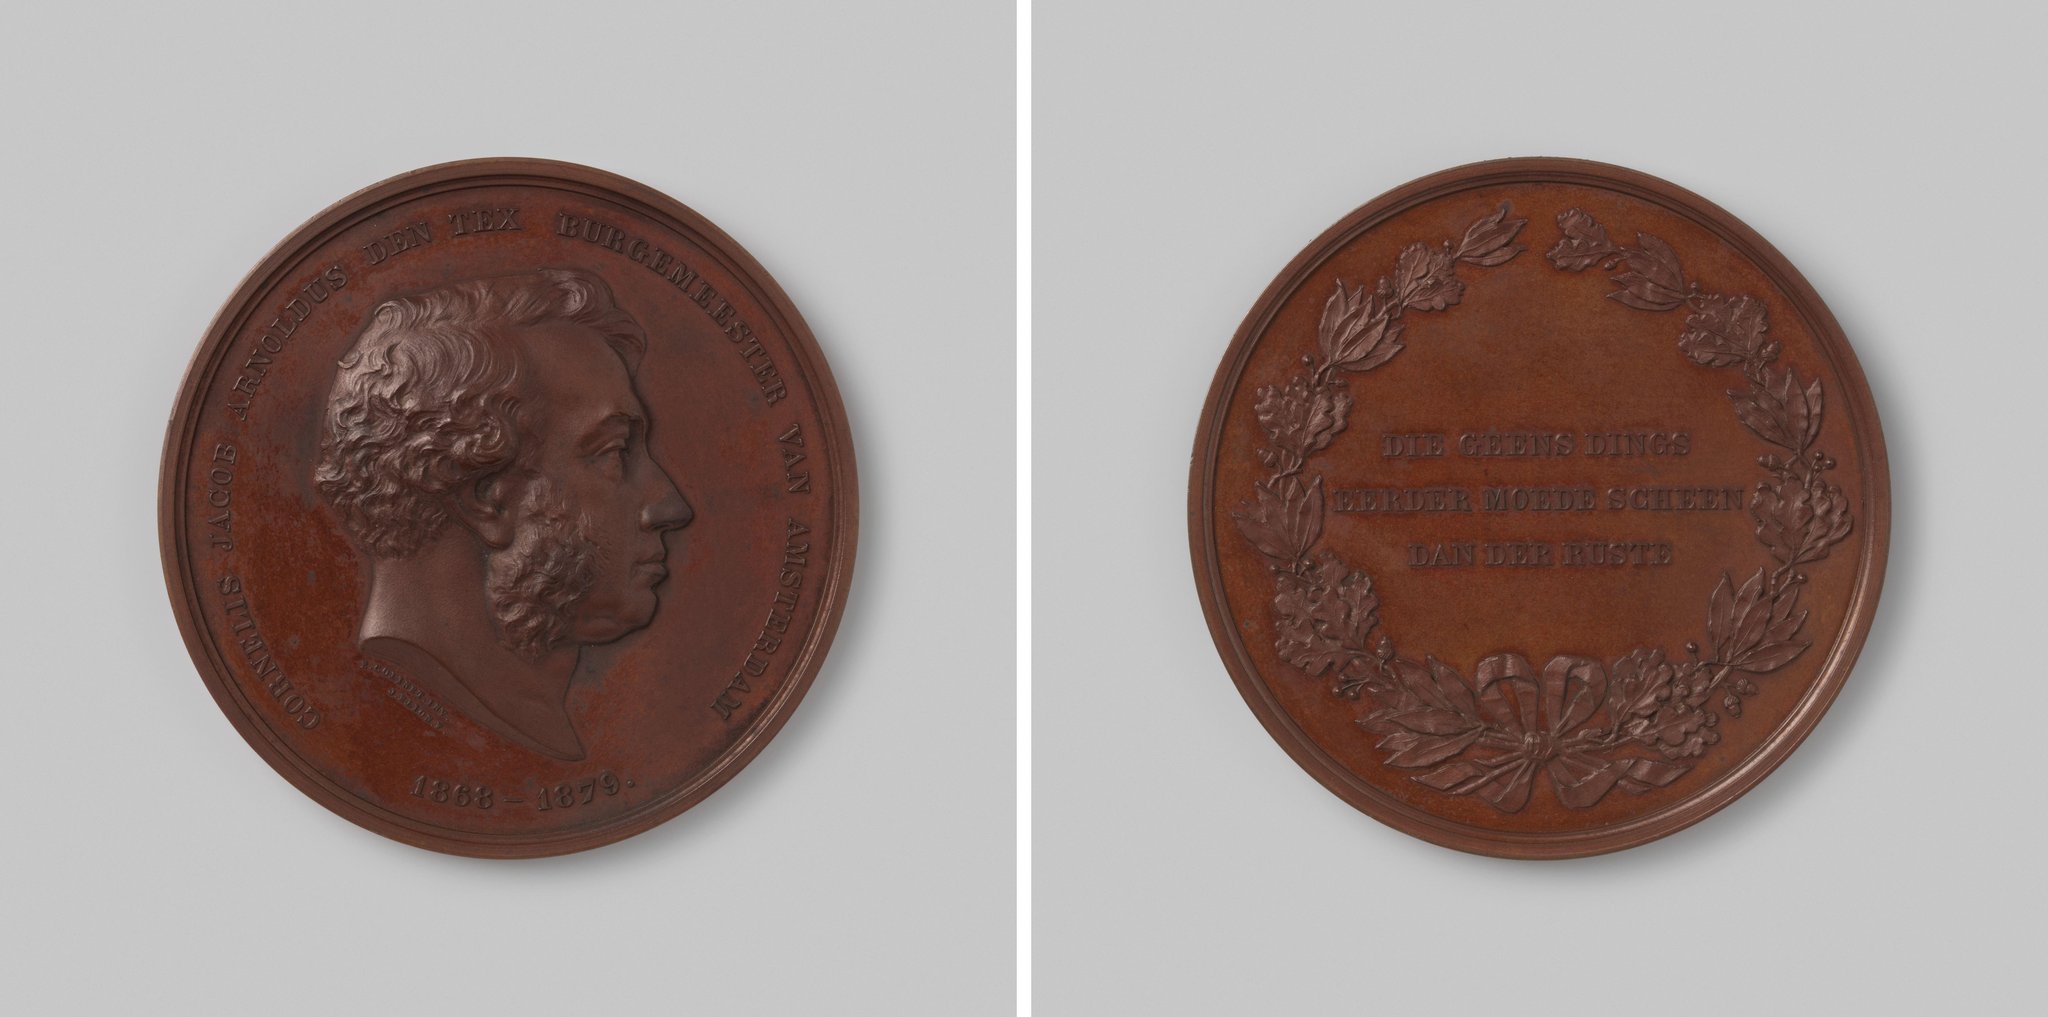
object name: history medal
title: Aftreden van Cornelis Jacob Arnoldus Den Tex als burgemeester van Amsterdam 1879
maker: jacob samuel cohen elion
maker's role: draughtsman, painter, print maker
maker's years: 1840-1893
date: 1879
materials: bronze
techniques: striking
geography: amsterdam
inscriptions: inscription: ‘KONINKLIJK OUDHEIDKUNDIG GENOOTSCHAP’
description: Bronzen penning, op de voorzijde het portret van Den Tex naar rechts met omschrift, op de keerzijde drie regels tekst tussen samengestrikte dubbele eiken- en lauwertakken. Met randinscriptie Koninklijk Oudheidkundig Genootschap.